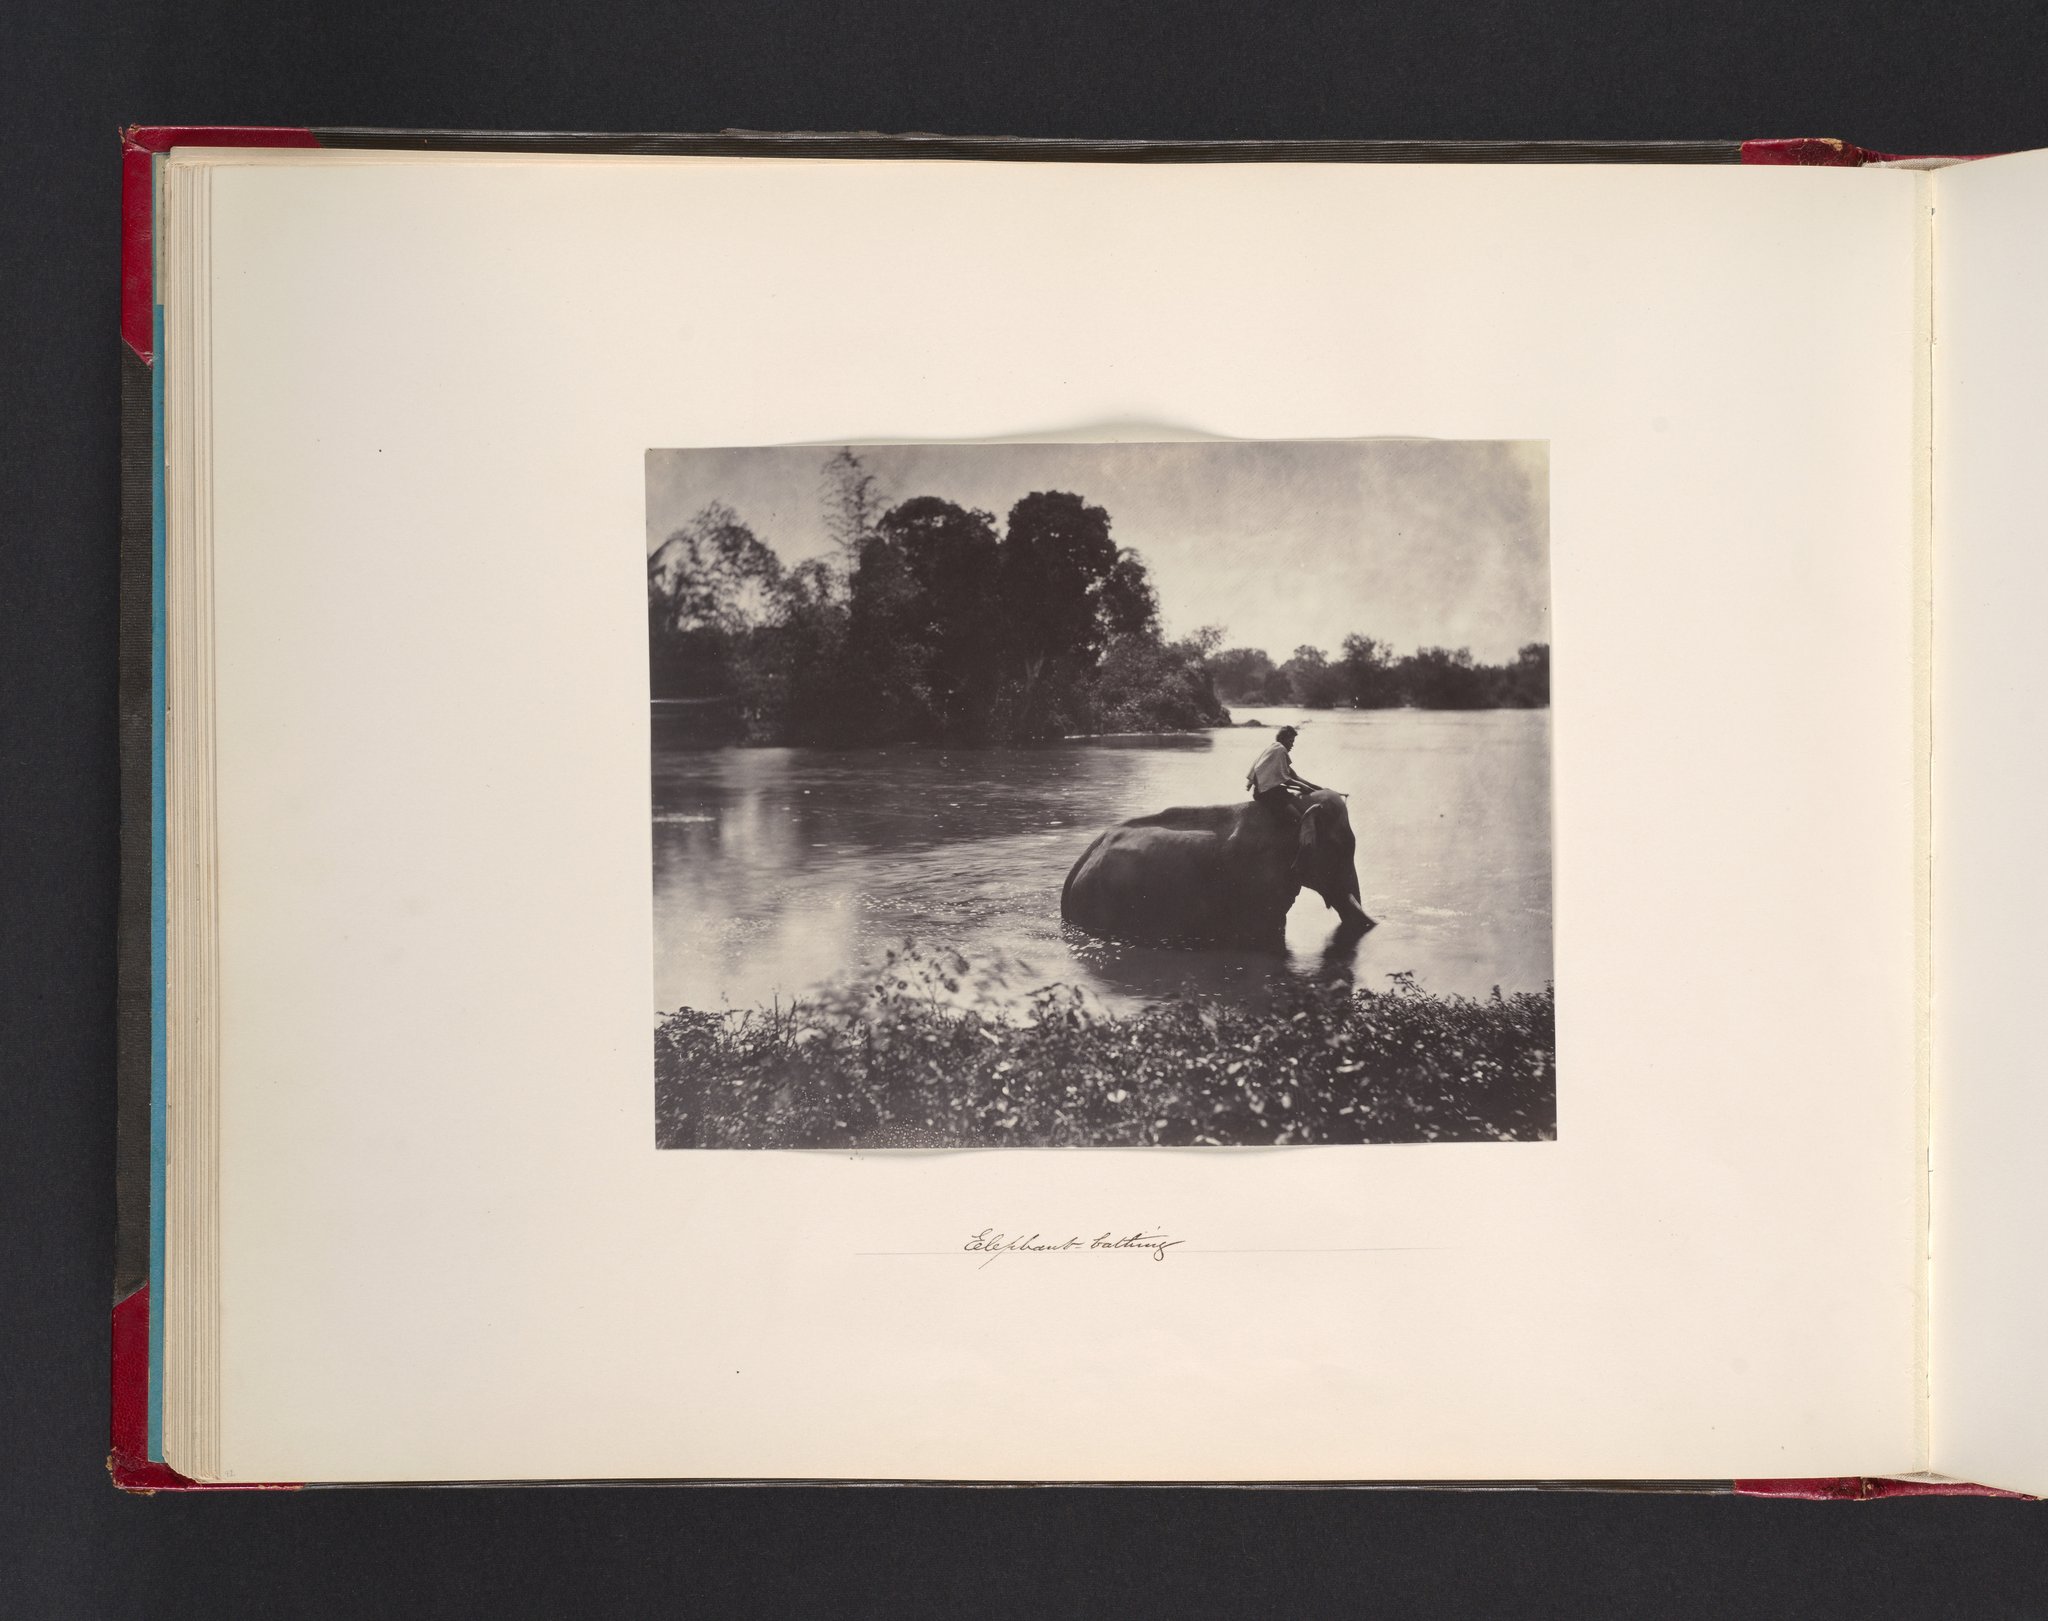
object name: photograph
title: Elephant Bathing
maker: john thomson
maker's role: artist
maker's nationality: british, scottish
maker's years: 1837-1921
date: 1865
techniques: albumen silver print, glass negative